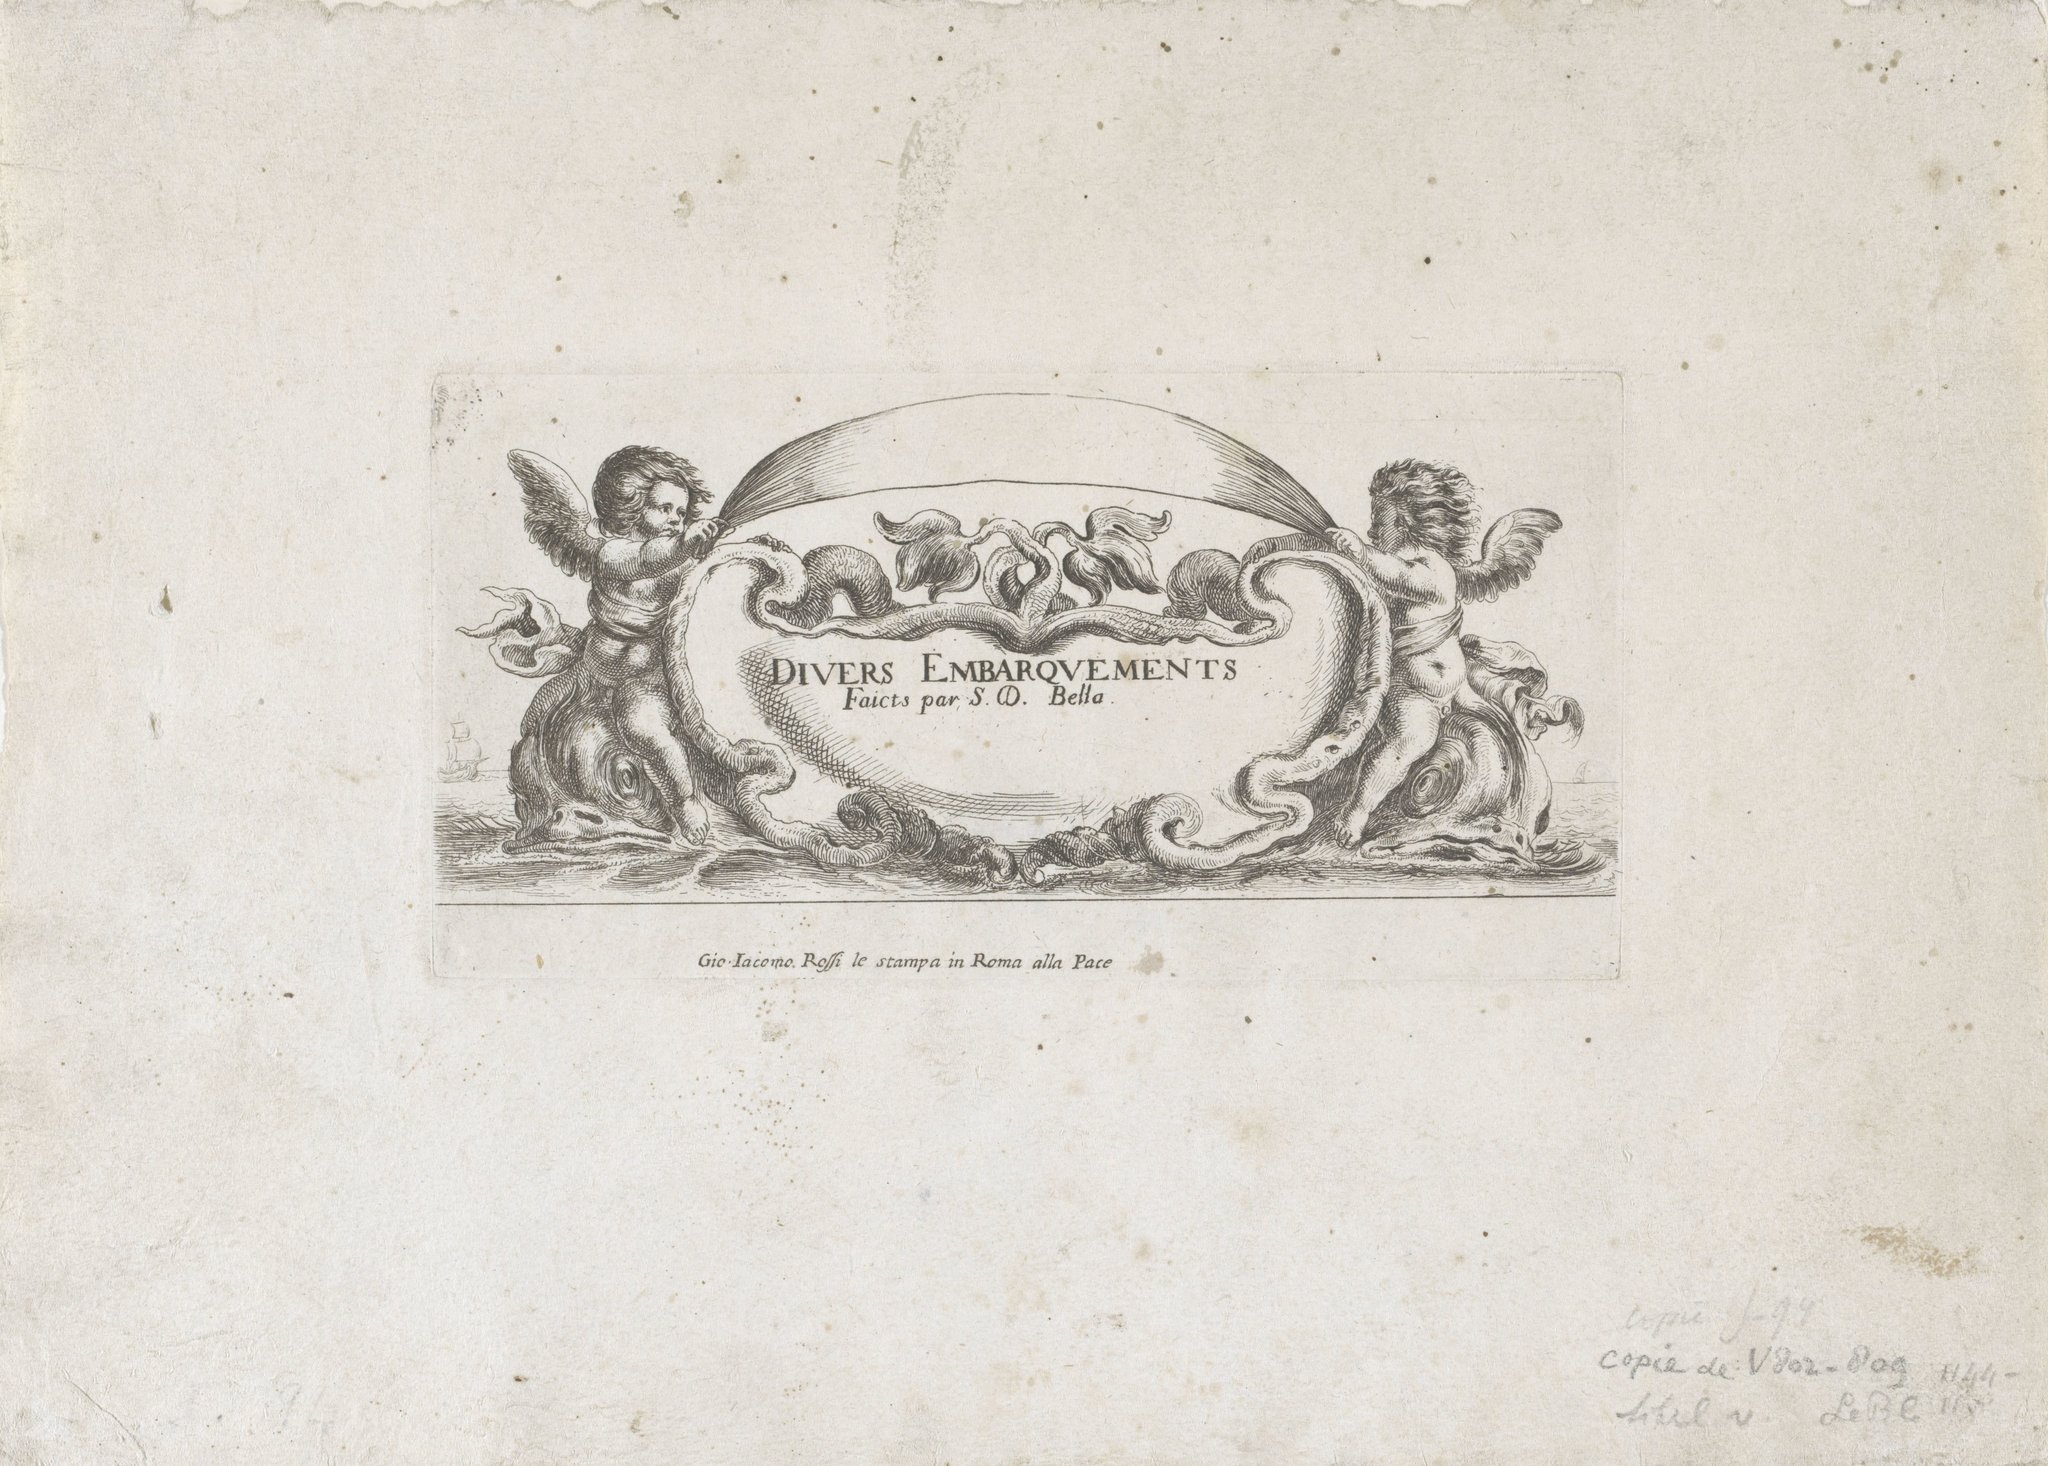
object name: print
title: Titelprent met cartouche met tekst geflankeerd door putti op dolfijnen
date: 1620-1664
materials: paper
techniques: etching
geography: rome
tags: swimming mammals: dolphin, ornament ~ cartouche, cupids: 'amores', 'amoretti', 'putti'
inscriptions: collector's mark: Lugt 2228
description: Titelprent bij een reeks van negen prenten. Zeven prenten zijn spiegelbeeldige en genummerde kopieën naar prenten van Stefano della Bella. Twee prenten zijn nieuwe inventies. Mogelijk is deze gekopieerde reeks ook door Della Bella zelf vervaardigd.